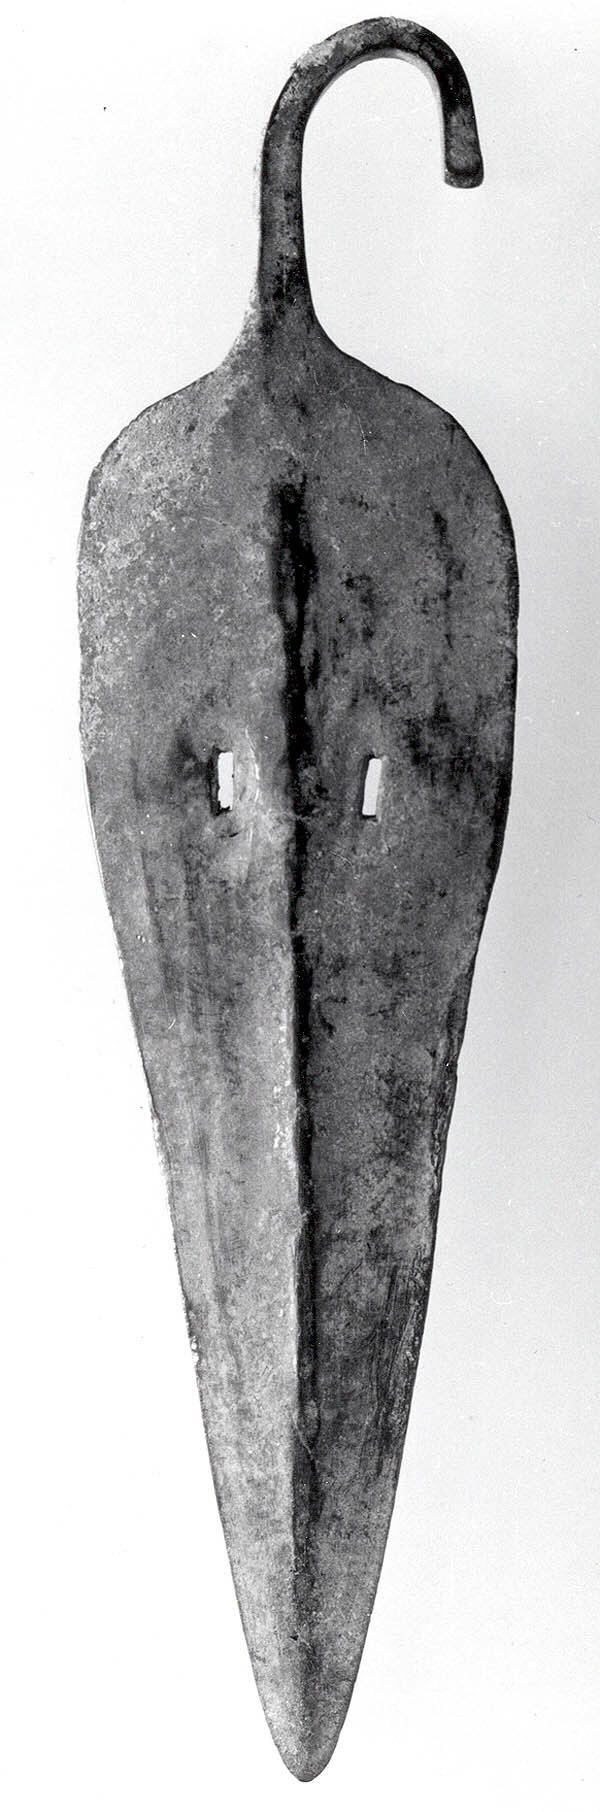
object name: spearhead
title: Spearhead with bent tang and slotted blade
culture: hattian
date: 2300-2000 BCE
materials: copper alloy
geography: central anatolia